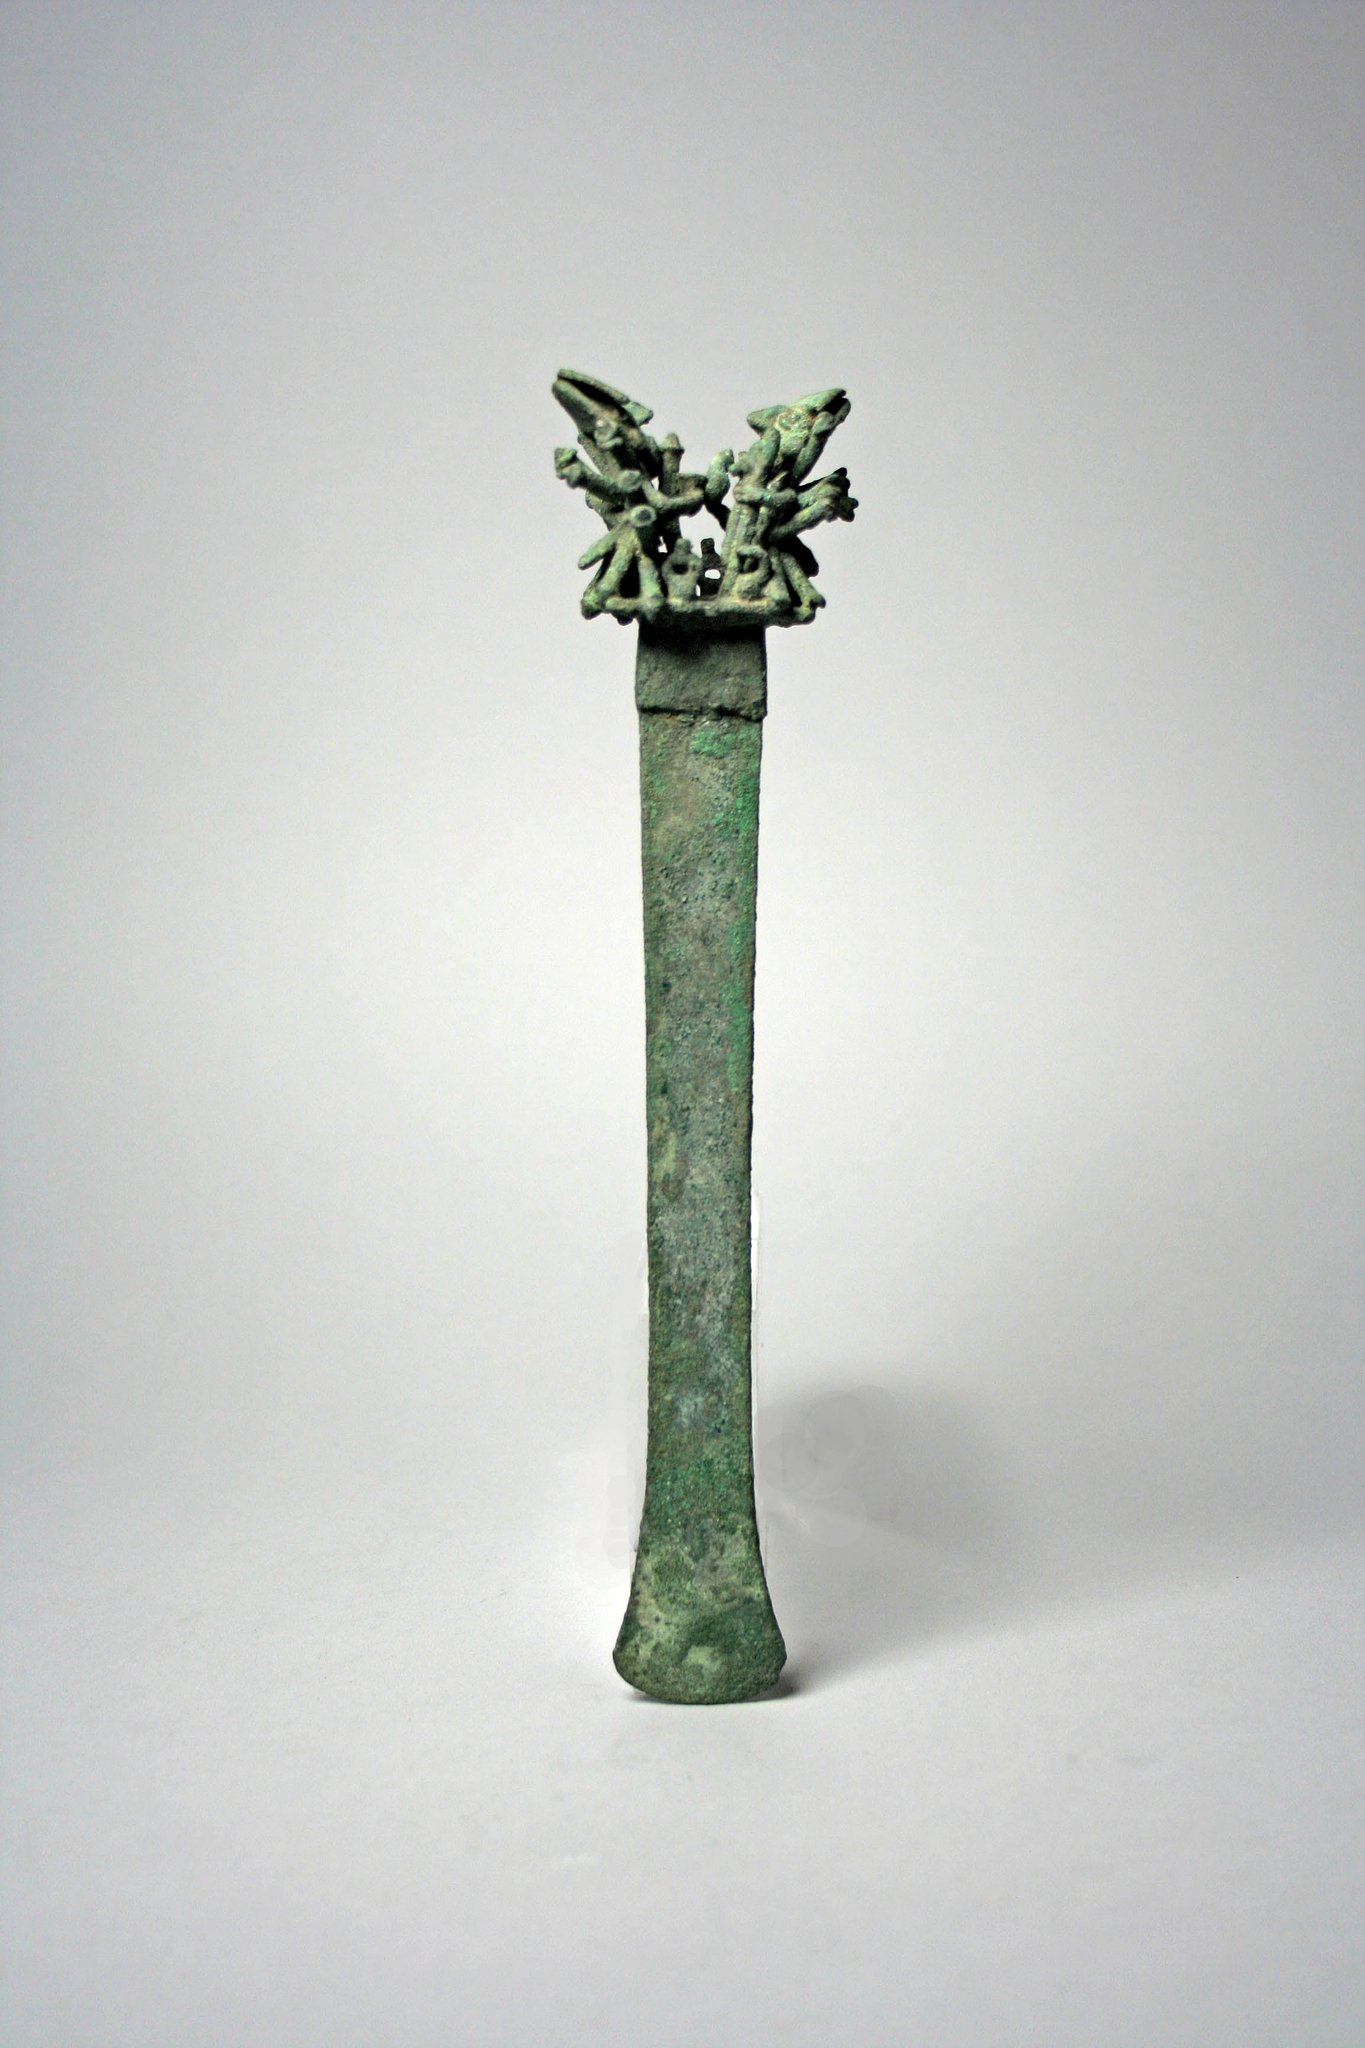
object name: chisel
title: Copper Chisel with Figures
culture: moche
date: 201-700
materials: copper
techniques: casting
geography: peru